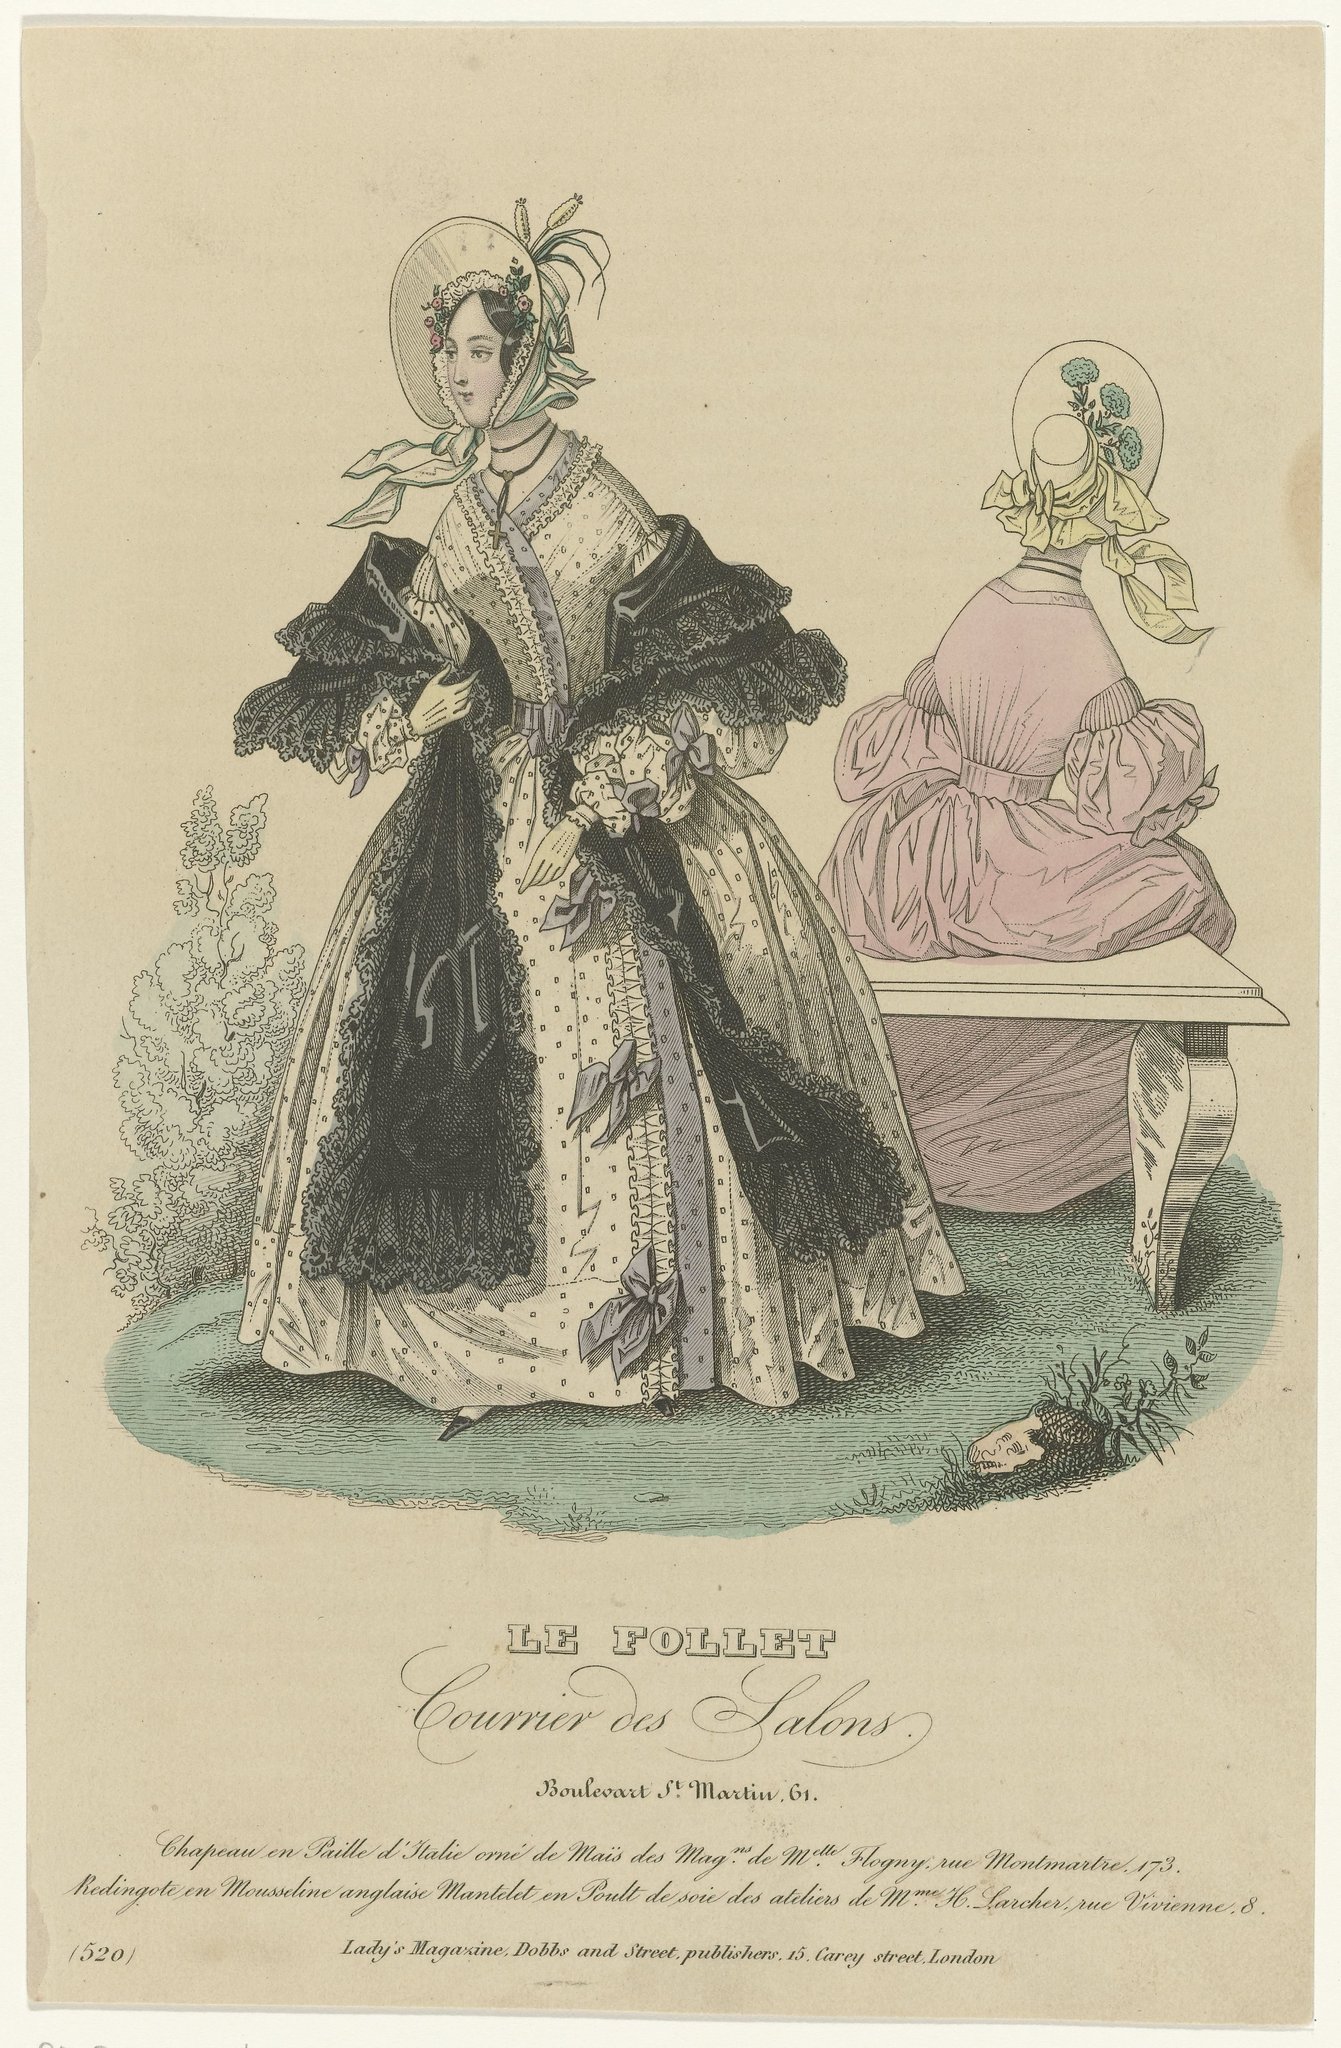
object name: fashion print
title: Le Follet, Courrier des Salons, ca. 1836, No. 520 : Chapeau en Paill (...)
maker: Anonymous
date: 1836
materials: paper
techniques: engraving, hand coloring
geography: london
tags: dress, gown: redingote (+ women's clothes), clothing for the upper part of the body (mantelet) (+ women's clothes), fashion plates, head-gear: hat (+ women's clothes), necklace (+ women's clothes)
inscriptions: address: ‘Lady's Magazine, Dobbs and Street, publishers, 15, Carey street, London’, title: ‘LE FOLLET / Courrier des Salons’, address: ‘Boulevart S.t Martin, 61’, caption: ‘Chapeau en Paille d'Italie orné de Maïs des Mag.ns de M.elle Flogny. rue Montmartre 173. Redingote en Mousseline anglaise Mantelet en Poult de soie des ateliers de M.me H. Larcher. rue Vivienne 8.’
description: Staande vrouw in een gestippelde redingote en mantelet. Collier met hanger in de vorm van een kruis. Zittende figuur, op de rug gezien, in eenzelfde redingote in het roze. Volgens het onderschrift: hoed van 'paille d'Italie' versierd met maïs uit de winkels van Flogny. Redingote van 'mousseline anglaise'. 'Mantelet' of kleine schoudermantel van 'poult de soie' uit de ateliers van H. Larcher. Prent uit het modetijdschrift Le Follet Courrier des Salons (1829 - 1882).